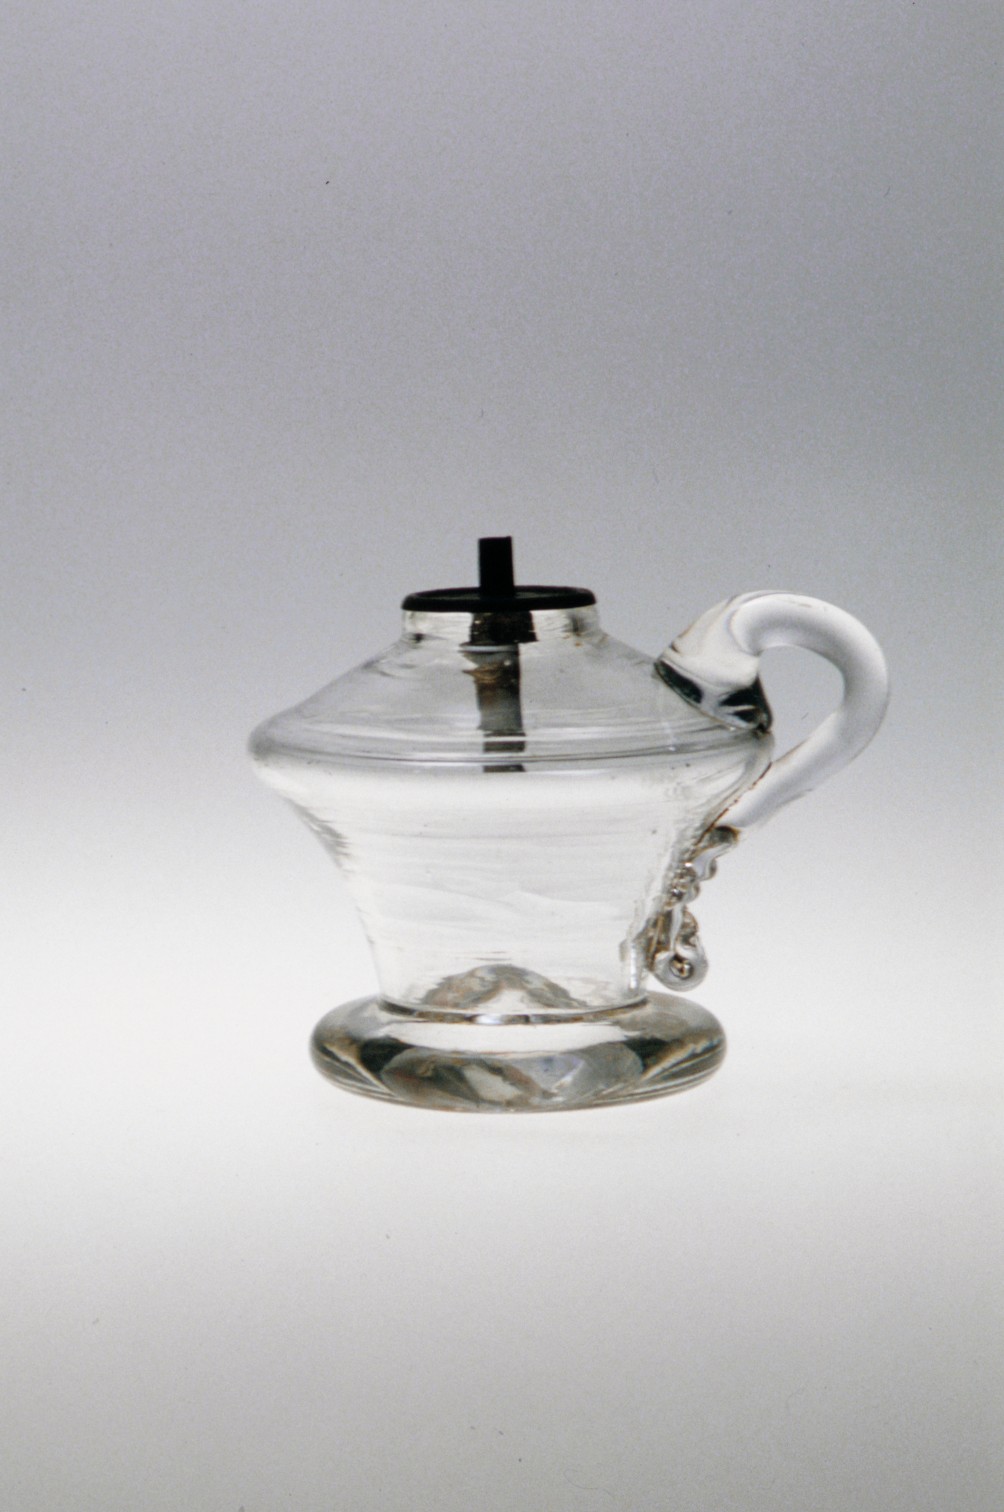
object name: whale oil lamp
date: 1830-1850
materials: glass, lead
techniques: glassblowing